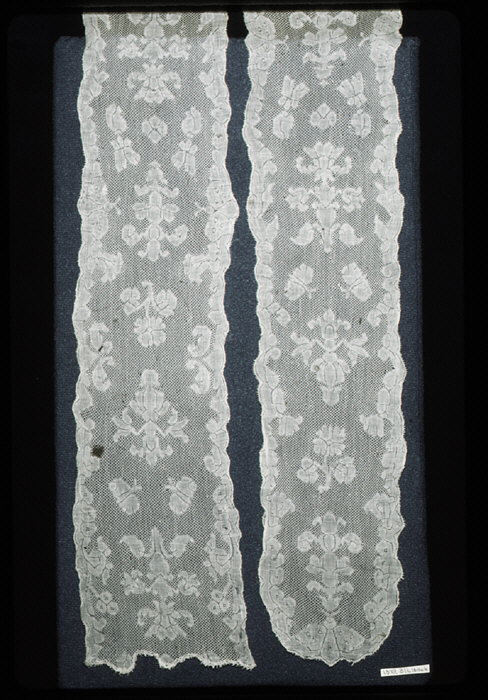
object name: lappet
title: Two joined lappets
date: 1751-1775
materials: linen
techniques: lace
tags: butterflies,flowers